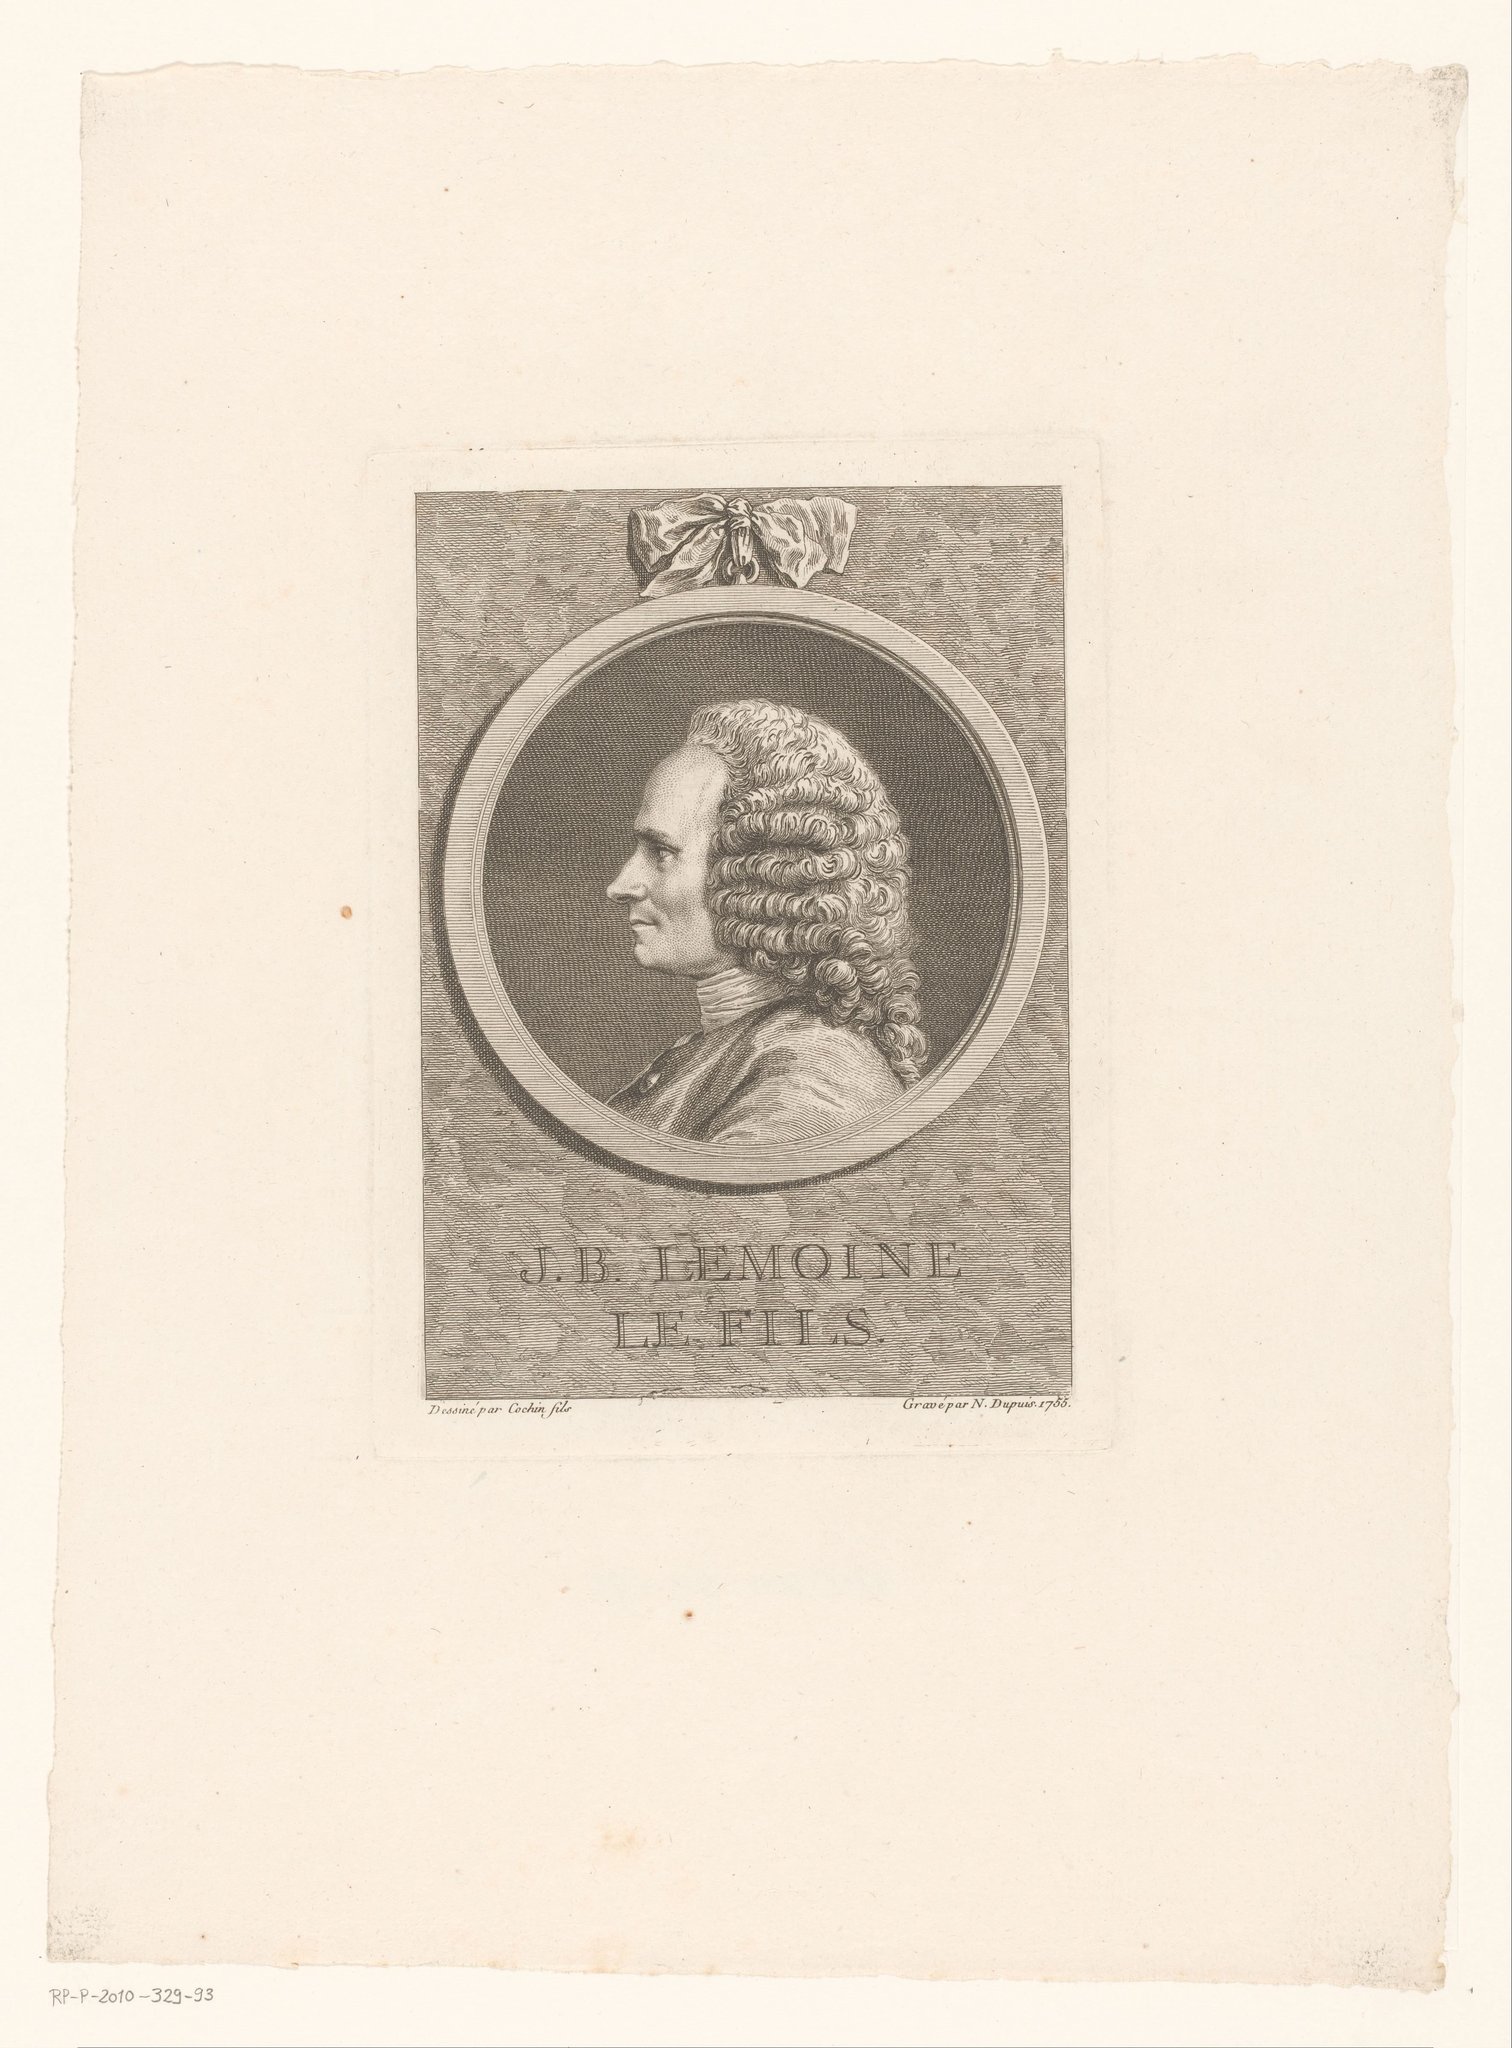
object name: print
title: J.B. Lemoine le fils.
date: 1755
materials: paper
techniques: etching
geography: france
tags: paris, sculptor, jean baptiste lemoyne (ii), portrait, self-portrait of sculptor, ornament ~ medallion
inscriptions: collector's mark: Lugt 2228